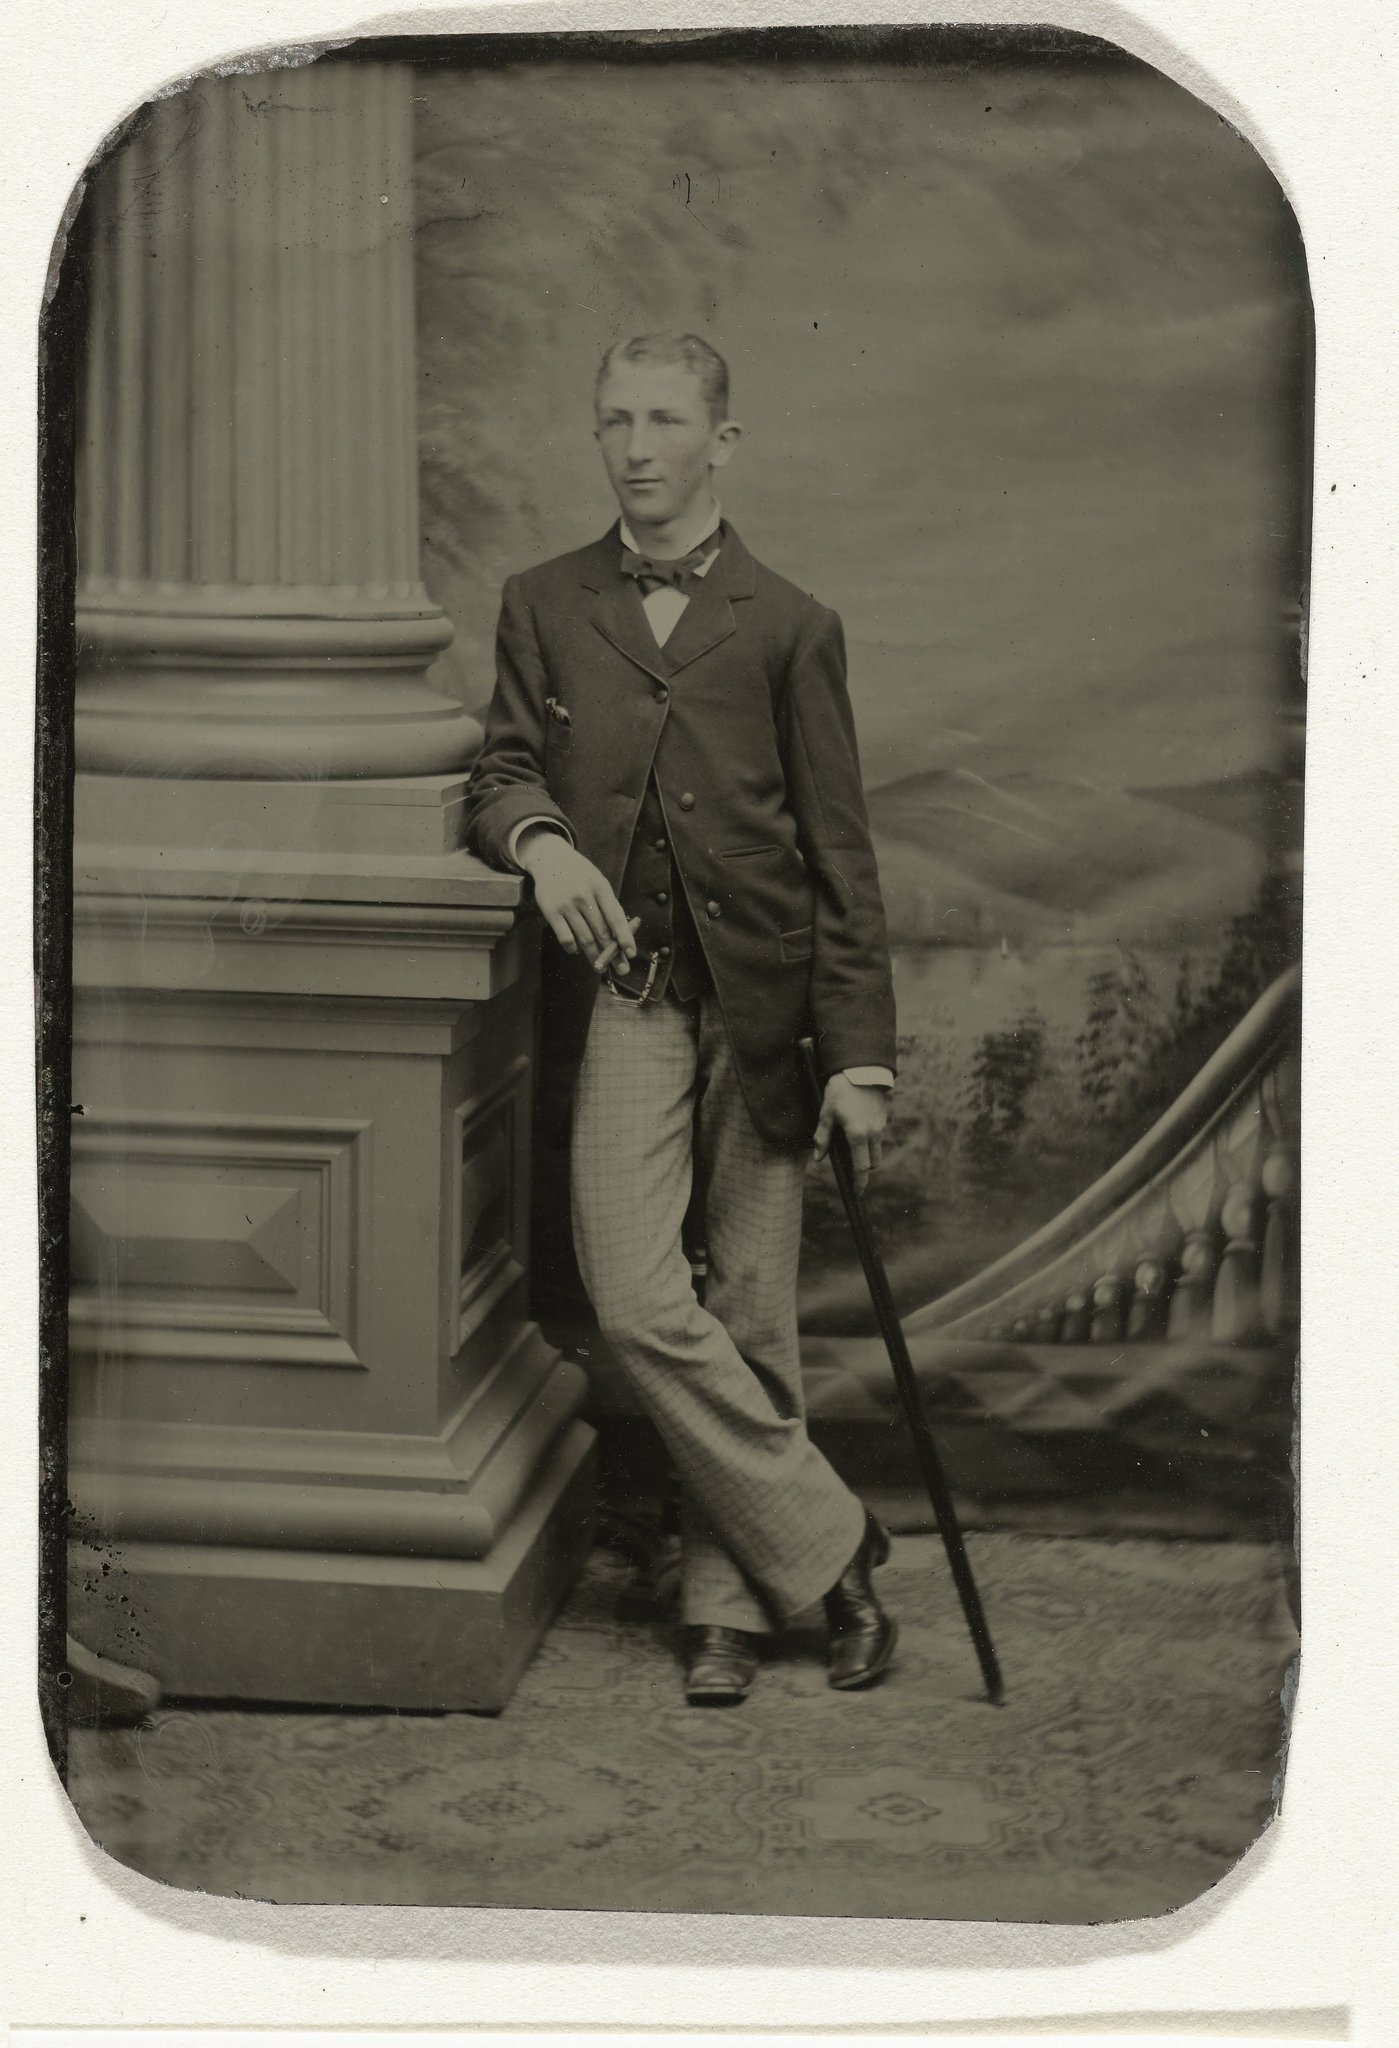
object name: photograph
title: Portret van een man, staand bij een zuil en voor een geschilderd achtergronddoek (landschap, trap en terras)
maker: Anonymous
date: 1880-1910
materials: metal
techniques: ferrotyping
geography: united states